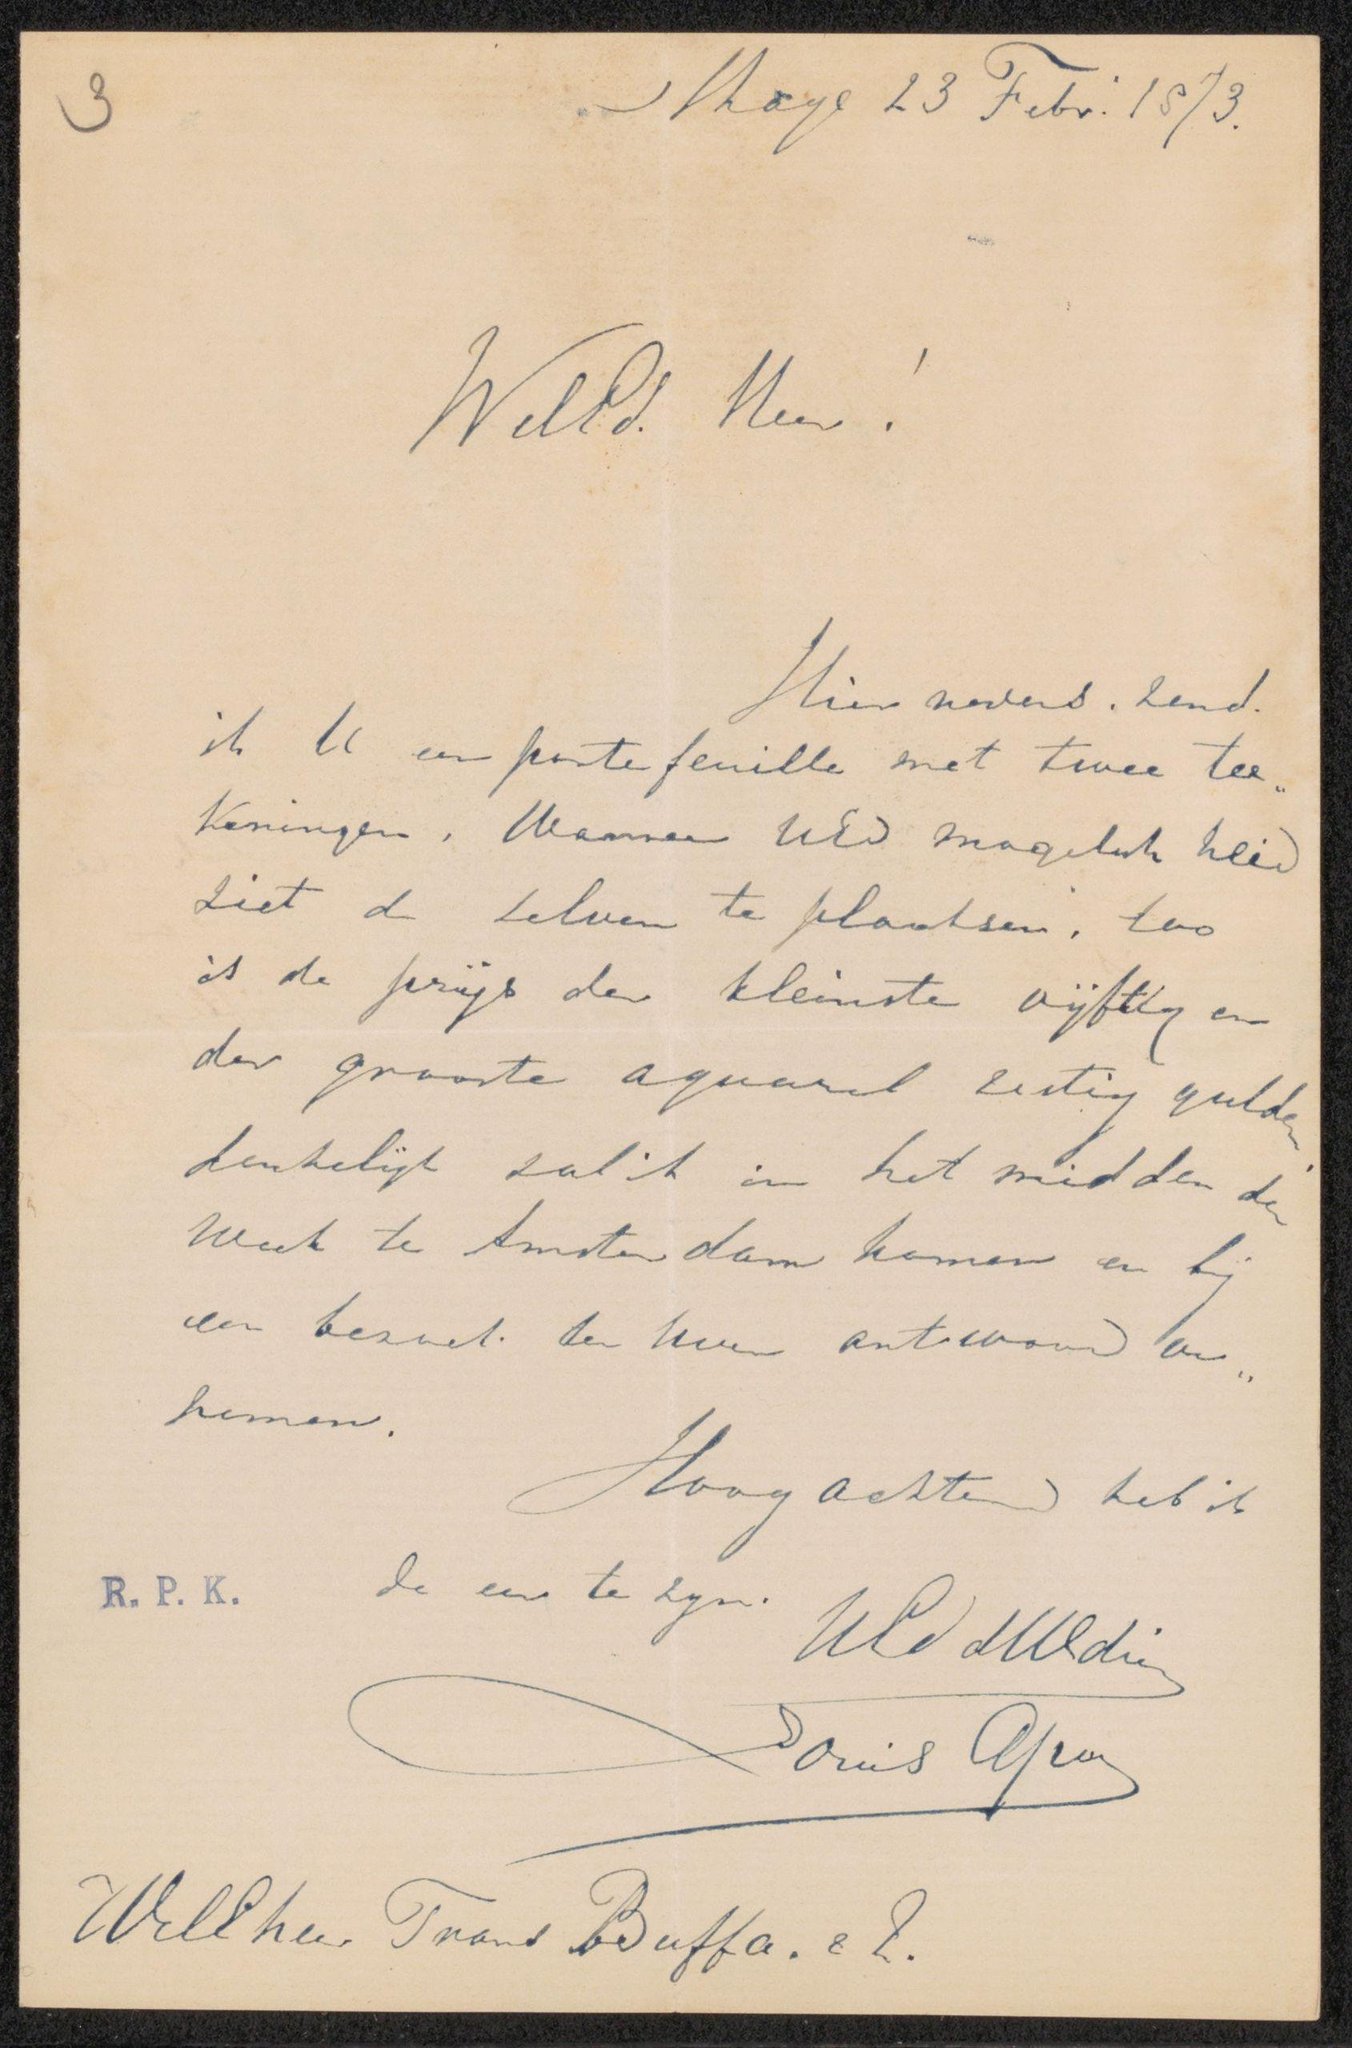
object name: letter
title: Brief aan Frans Buffa en Zonen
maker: louis apol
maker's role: draughtsman, painter, print maker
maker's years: 1850-1936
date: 1873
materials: ink, paper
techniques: pen, writing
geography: the hague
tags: drawing, money, amsterdam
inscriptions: collector's mark: Lugt 2233